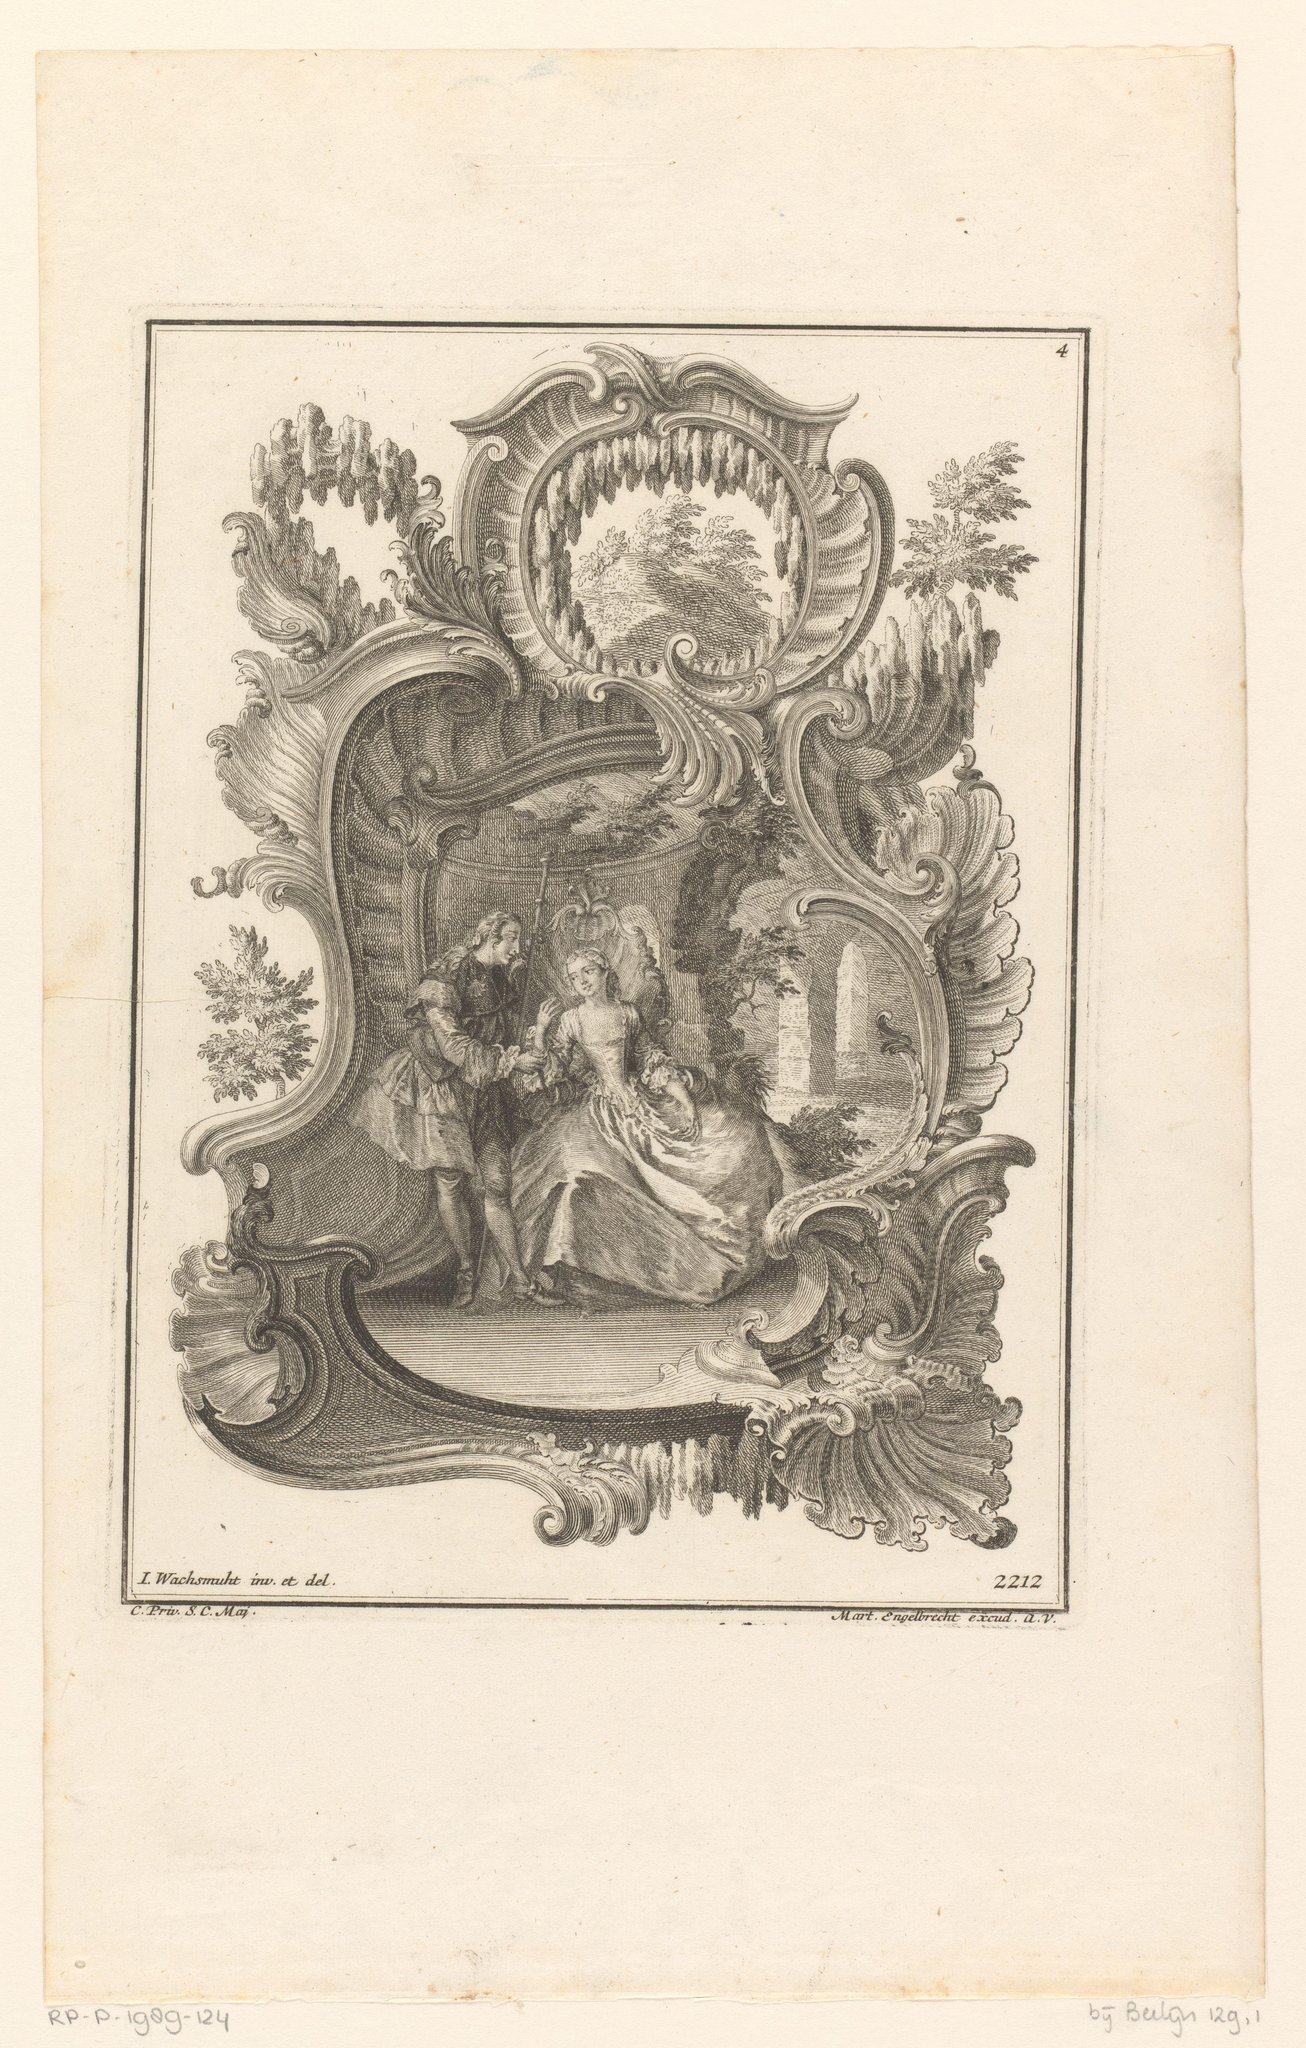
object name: print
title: Twee pelgrims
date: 1721-1756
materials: paper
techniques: etching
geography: augsburg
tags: pilgrim(s), pastorals, arcadian scenes, couple of lovers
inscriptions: collector's mark: Lugt 2760, collector's mark: Lugt 2228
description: In een rocaille ornament zit een vrouwelijke pelgrim. Naast haar staat een mannelijke pelgrim, hij pakt haar arm. Prentnummer 2212.